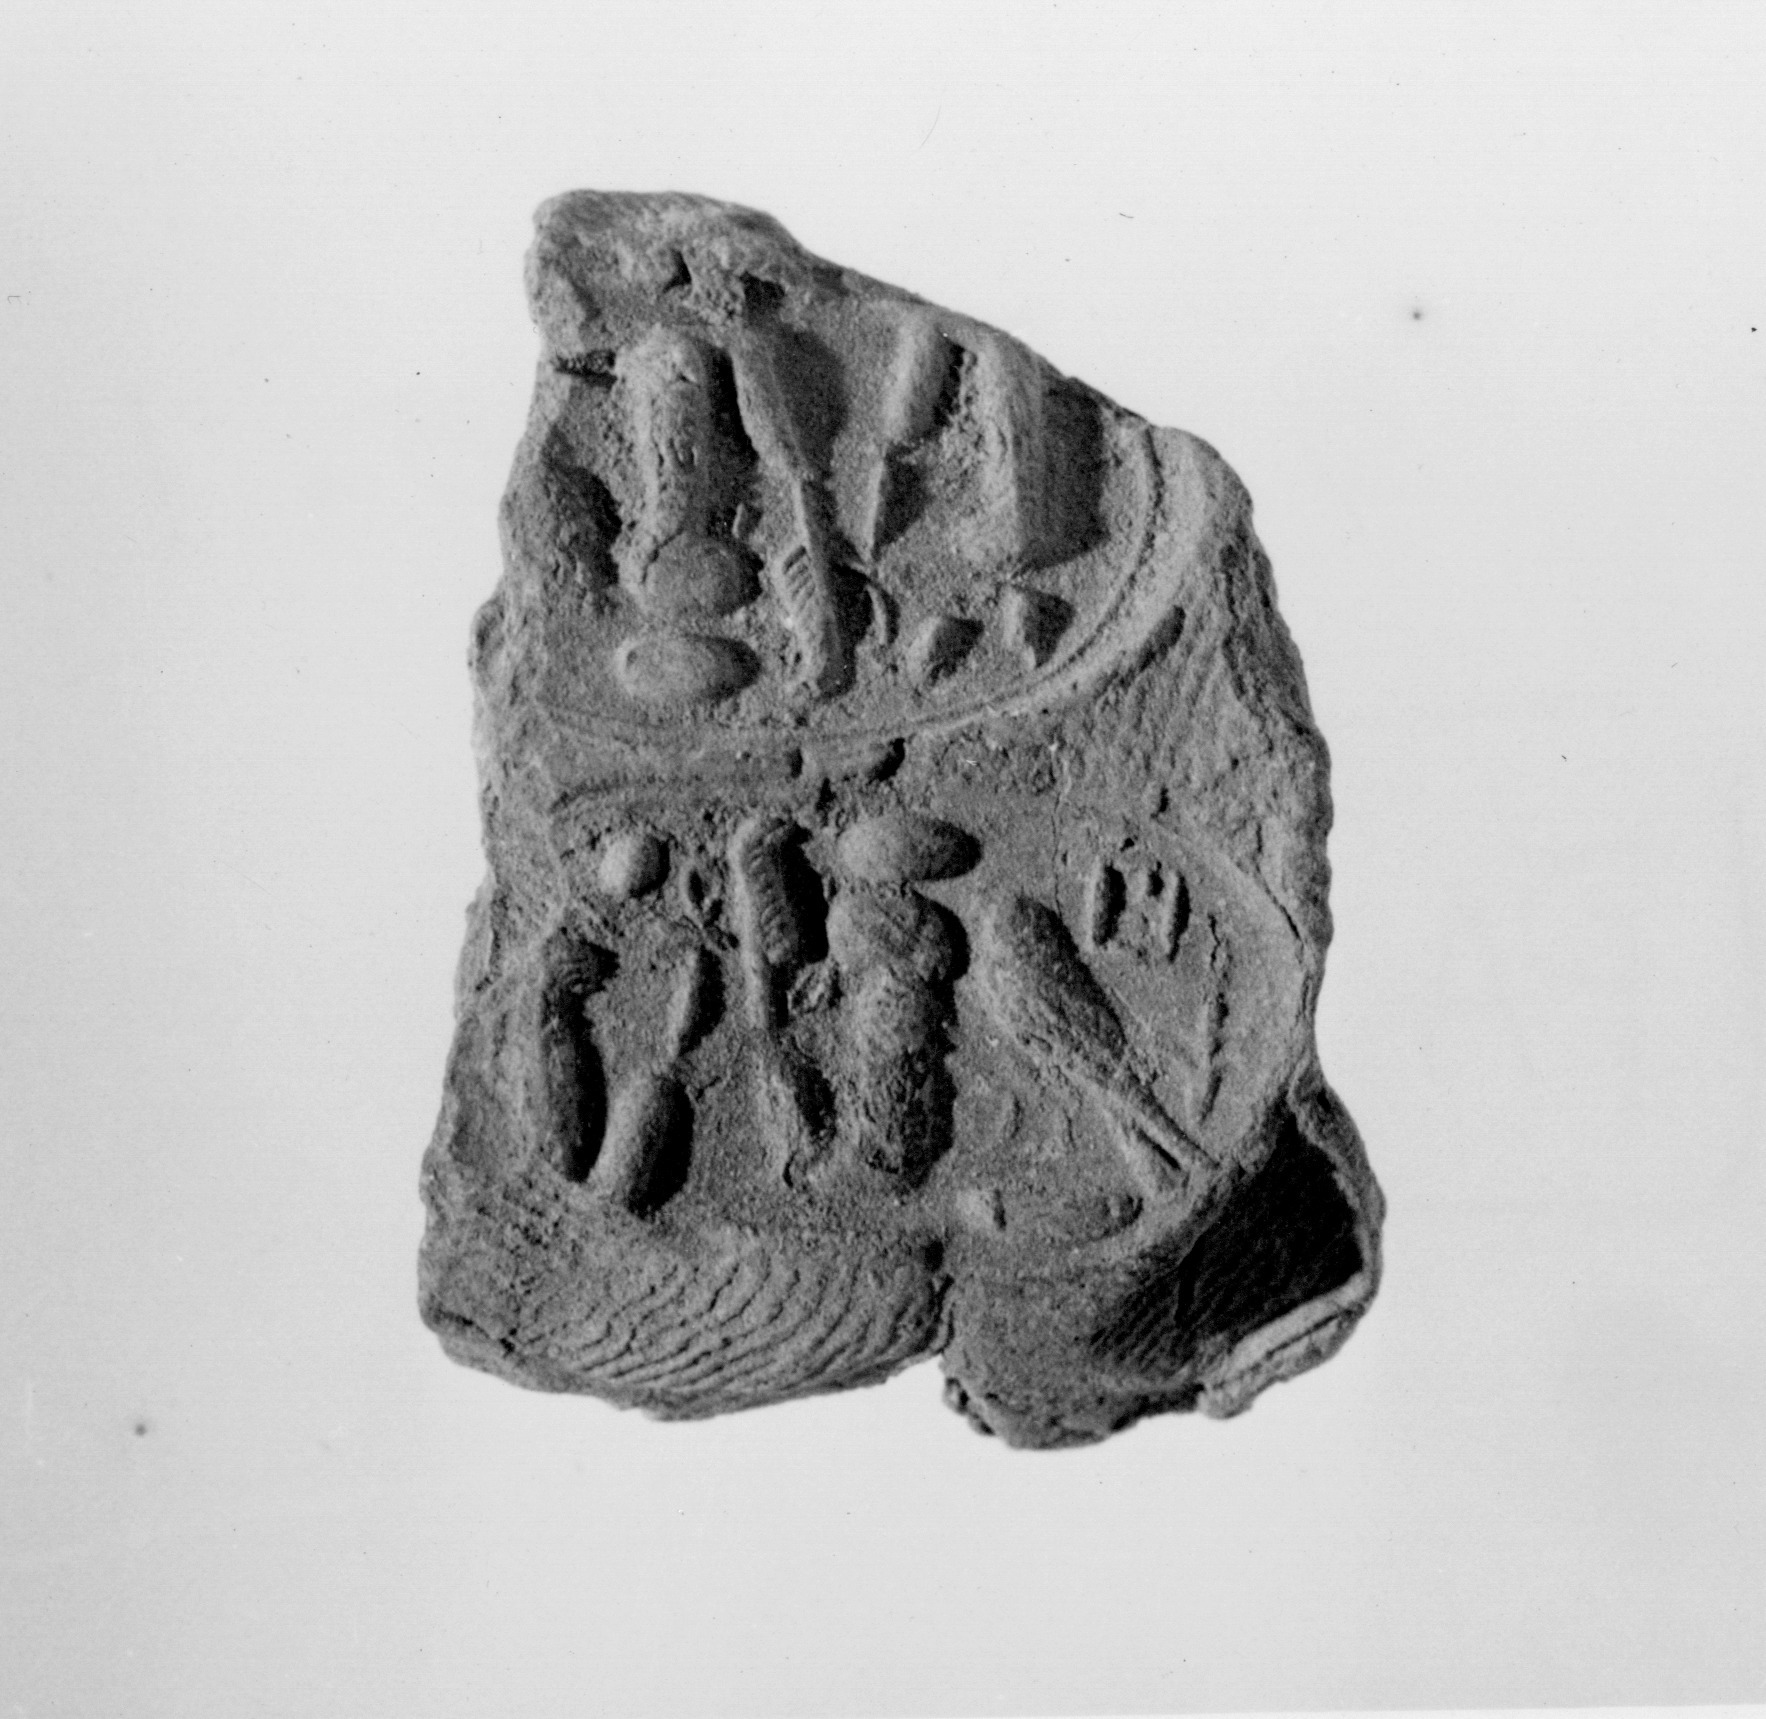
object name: sealing, nebmaatre, amenhotep iii, isi, horus, ke nesu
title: Document Sealing With the Throne Name of Amenhotep III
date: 1390-1352 BCE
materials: mud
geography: egypt